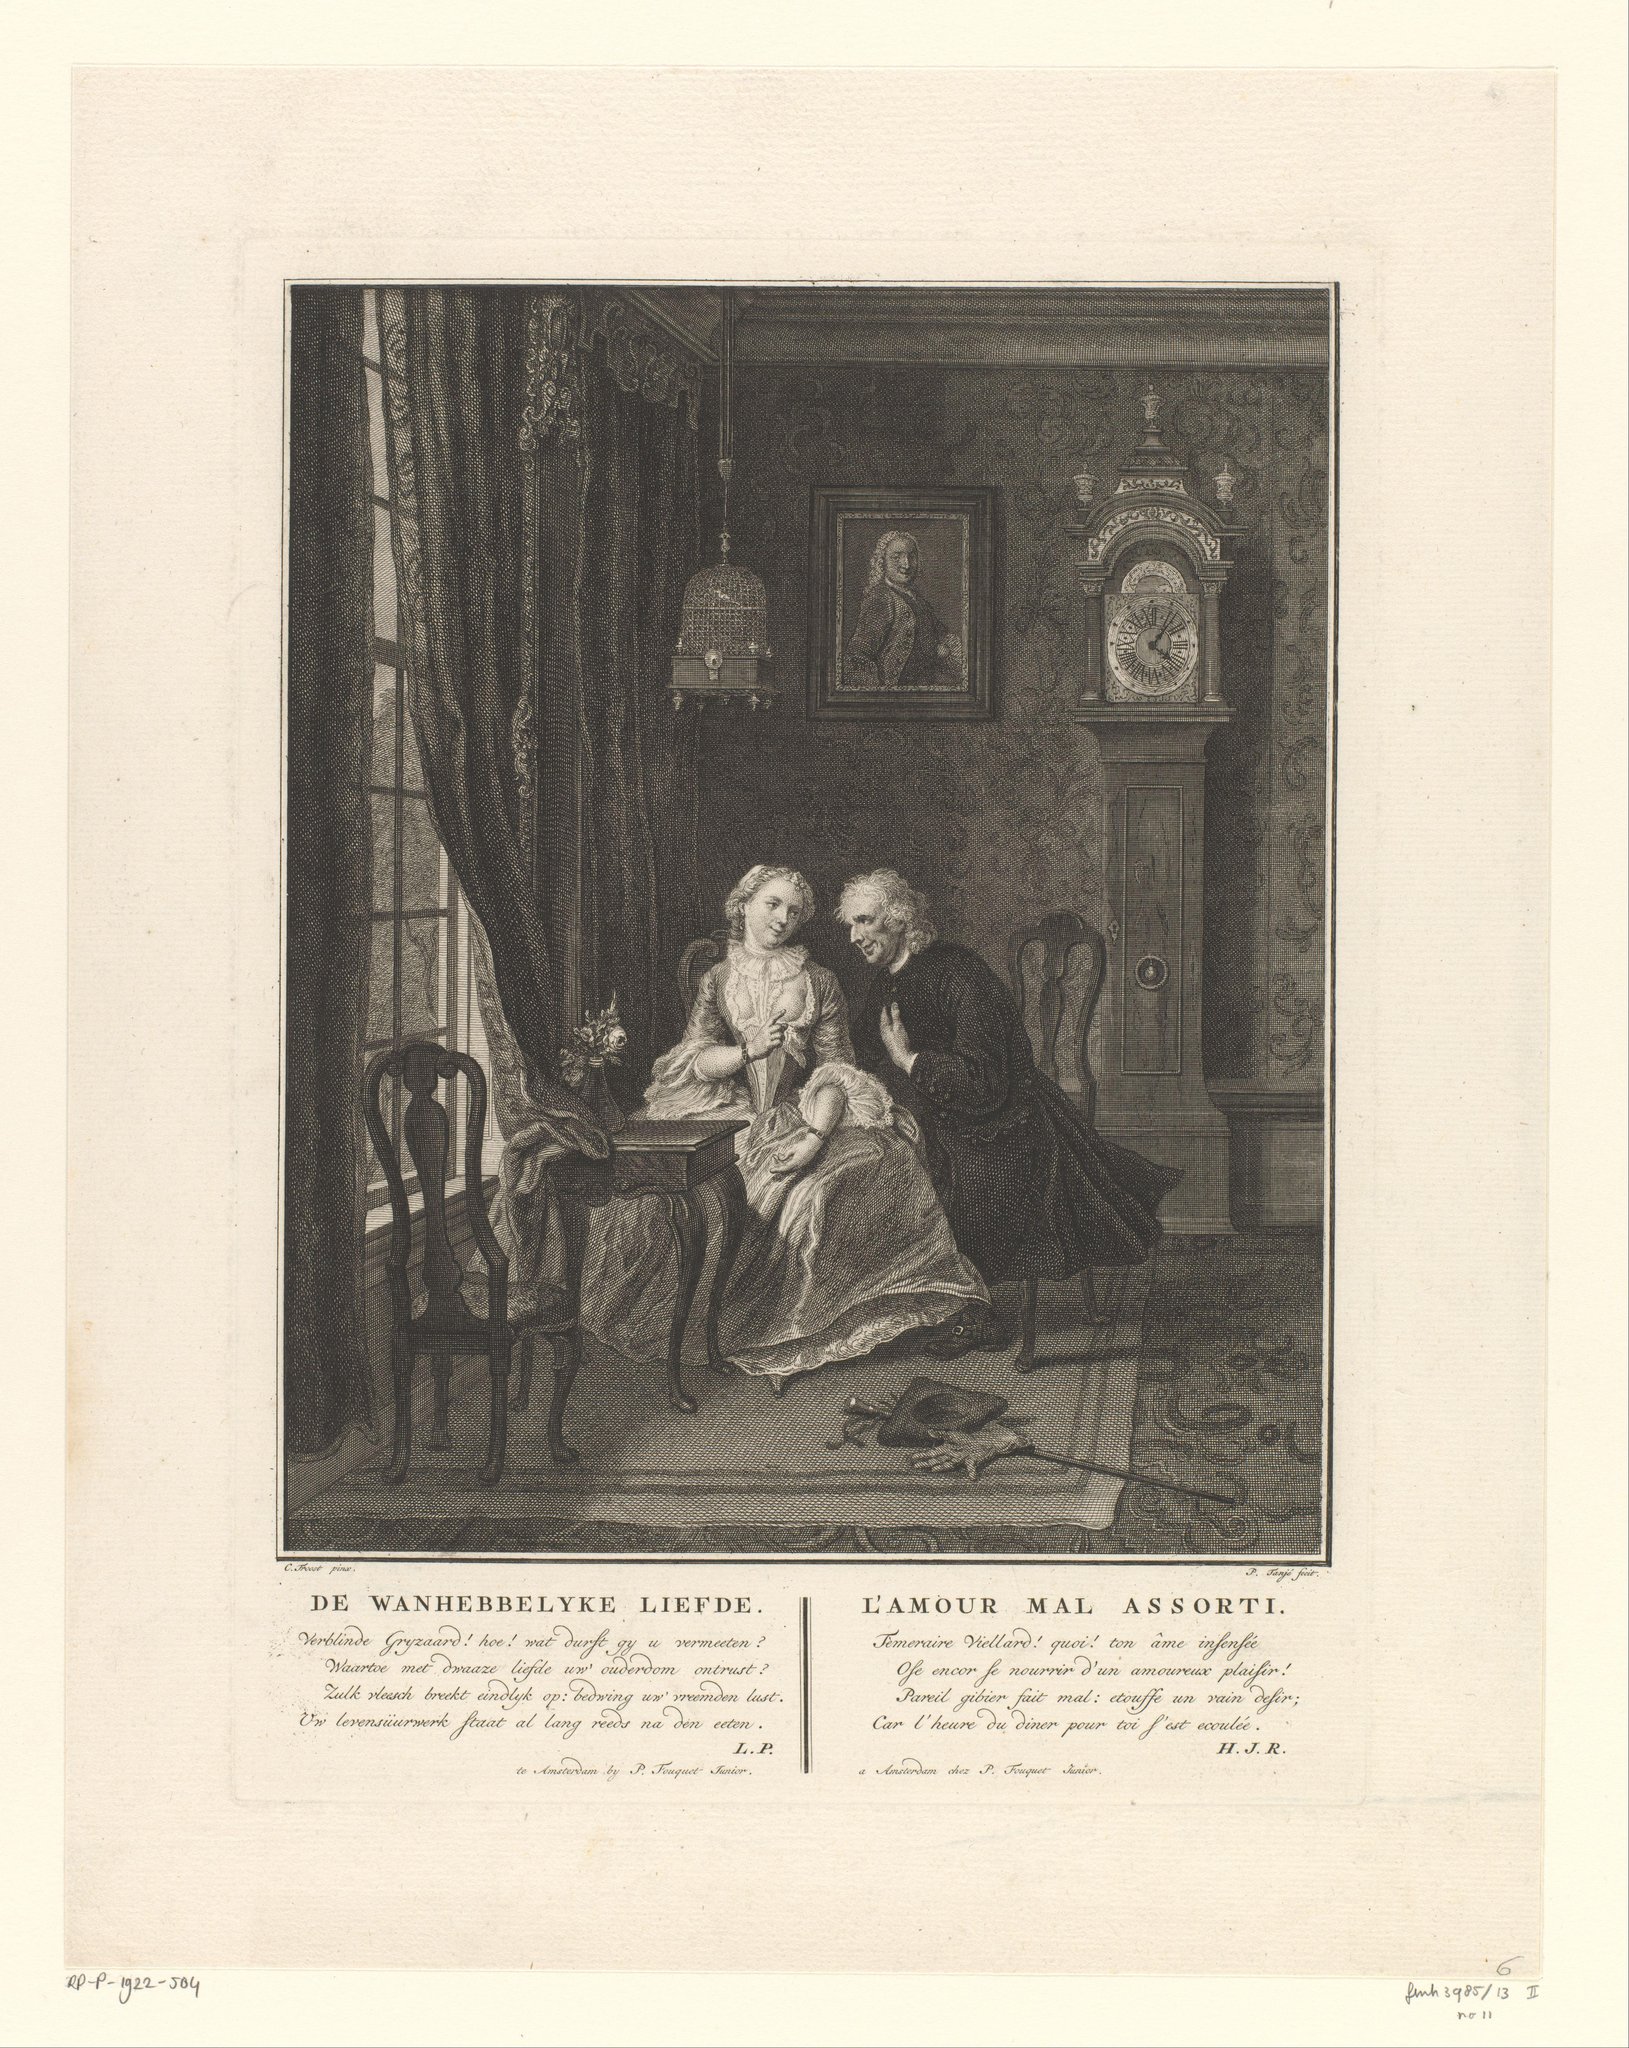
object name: print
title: Wanhebbelijke liefde: weduwnaar Joost en Lucia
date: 1752-1761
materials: paper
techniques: engraving, etching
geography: amsterdam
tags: unequal couple, ill-matched couple, living-room, parlour, sitting-room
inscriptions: collector's mark: Lugt 2233, collector's mark: Lugt 2228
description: Joost, een oude weduwnaar en de vader van Lucia's geliefde, bekent aan Lucia zijn liefde. Onderaan in de marge een vierregelig vers in het Nederlands en het Frans. Scène uit het toneelstuk De wanhébbelyke liefde, van Philippe Quinault.